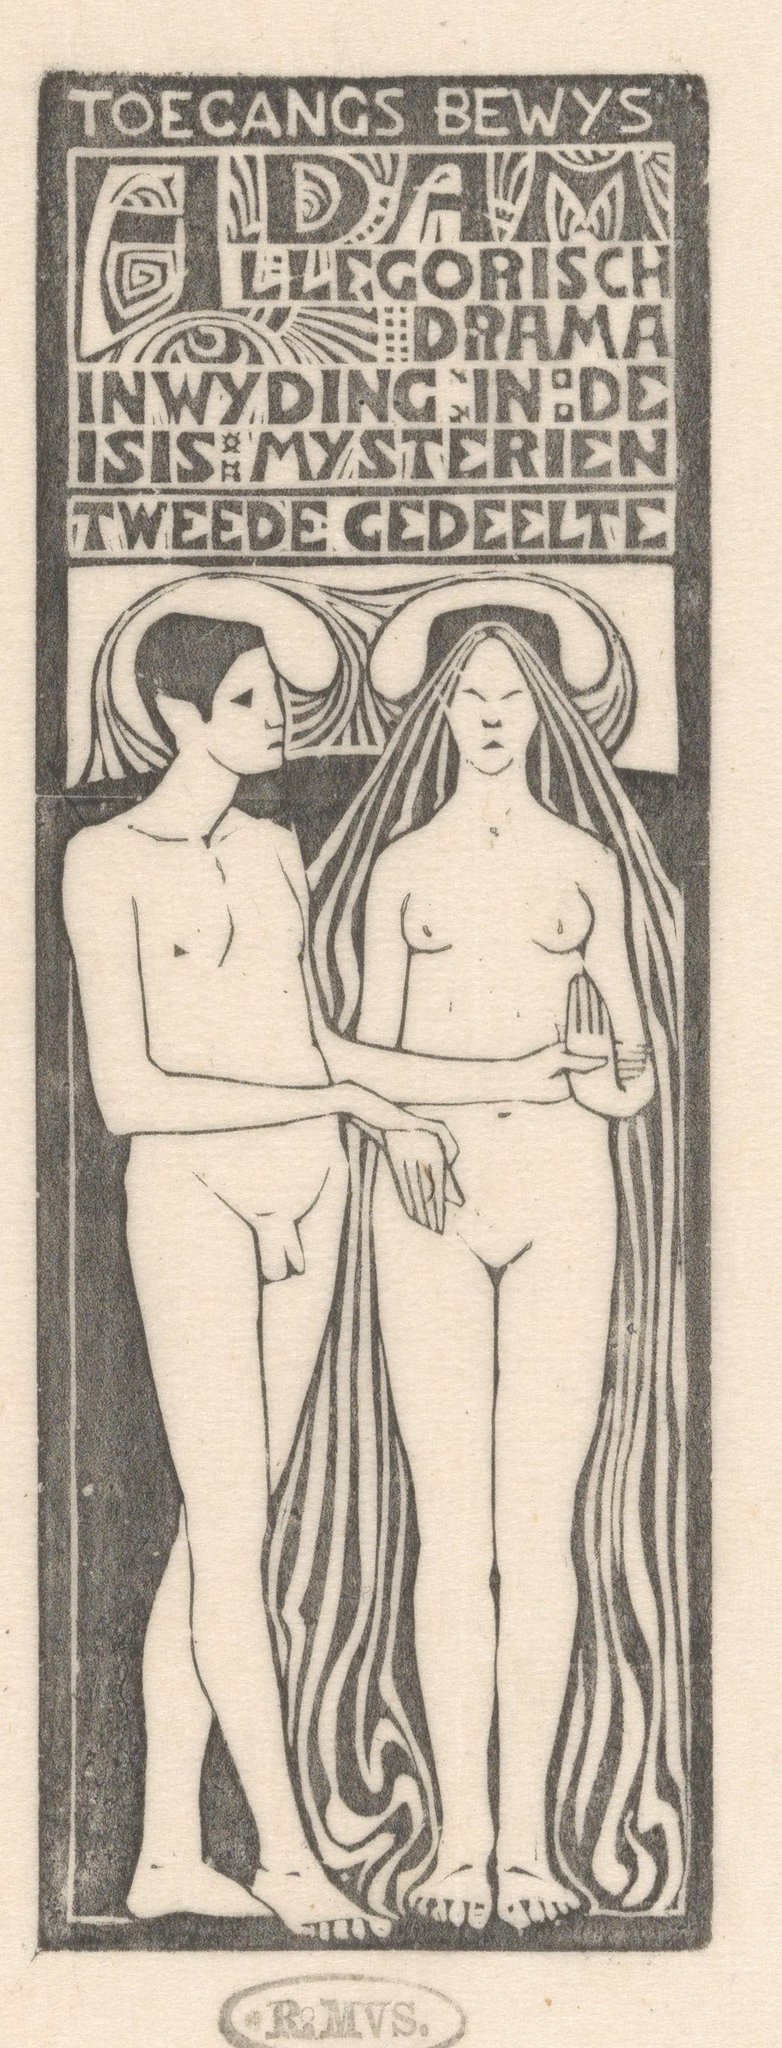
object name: admission ticket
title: Toegangsbewijs voor deel twee van Adam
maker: karel petrus cornelis de bazel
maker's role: draughtsman, print maker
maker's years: 1869-1923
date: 1912-1934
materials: paper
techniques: woodcut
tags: adam and eve (not in biblical context), printed matter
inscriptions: collector's mark: Lugt 2228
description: Toegangskaart voor het tweede gedeelte van het allegorisch drama 'Adam', 'Een inwijding in de Isis mysteriën', met een afbeelding van een naakte, staande Adam en Eva.